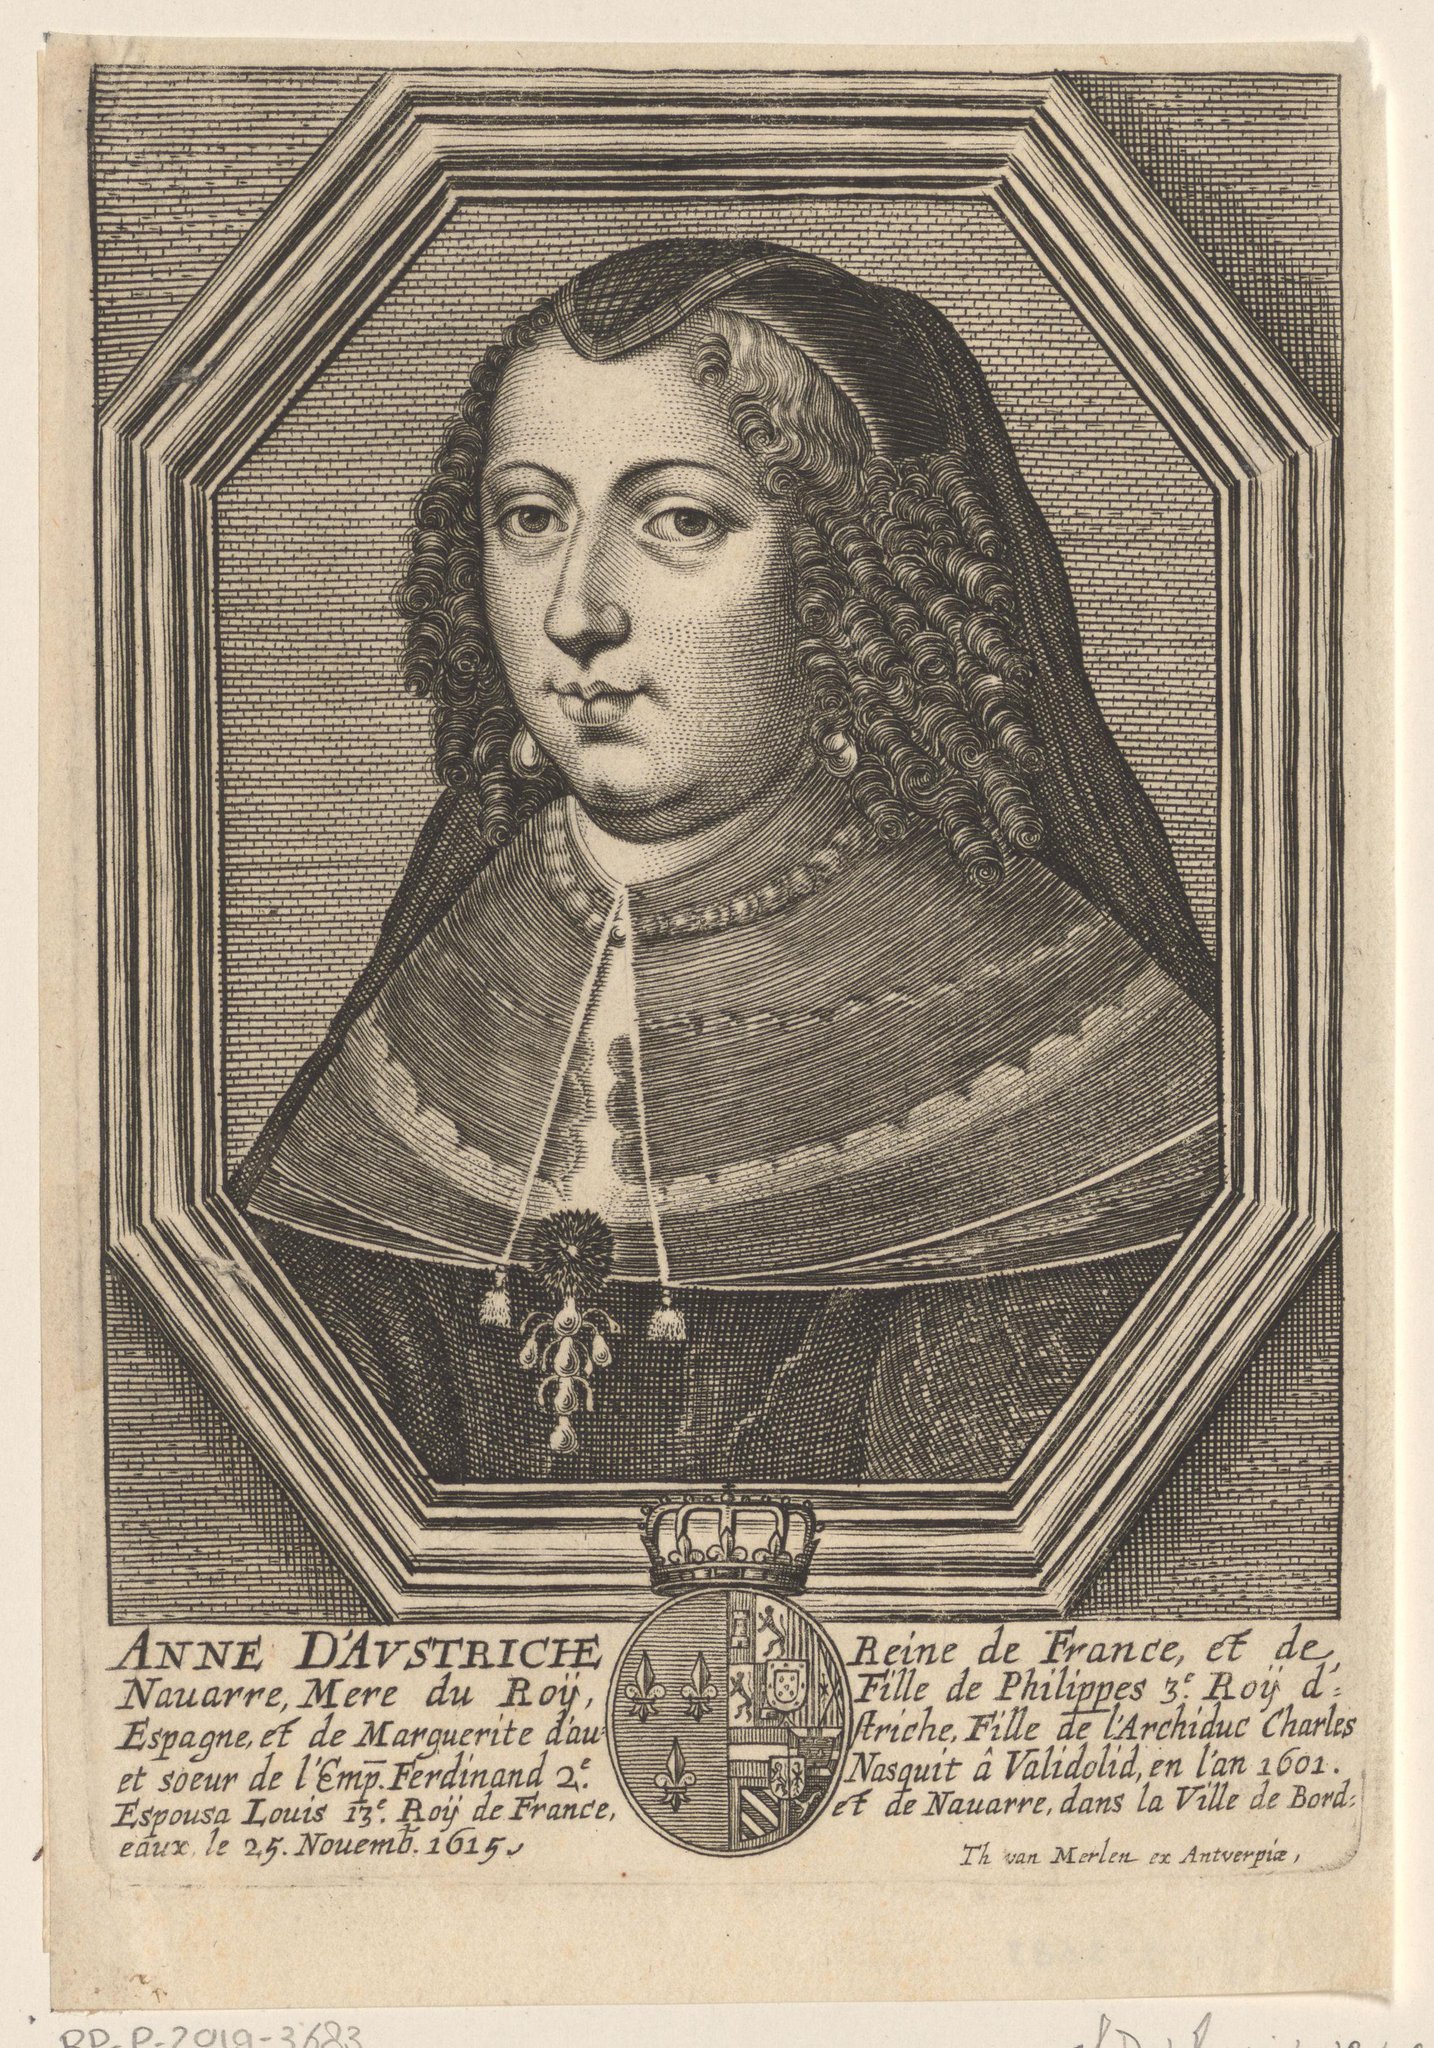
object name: print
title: Portret van Anna van Oostenrijk, koningin van Frankrijk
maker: theodor van merlen (ii)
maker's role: print maker, publisher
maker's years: 1609-1672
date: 1643-1672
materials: paper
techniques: engraving, etching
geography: antwerp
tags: anna van oostenrijk (koningin van frankrijk), historical persons - bb - woman, armorial bearing, heraldry